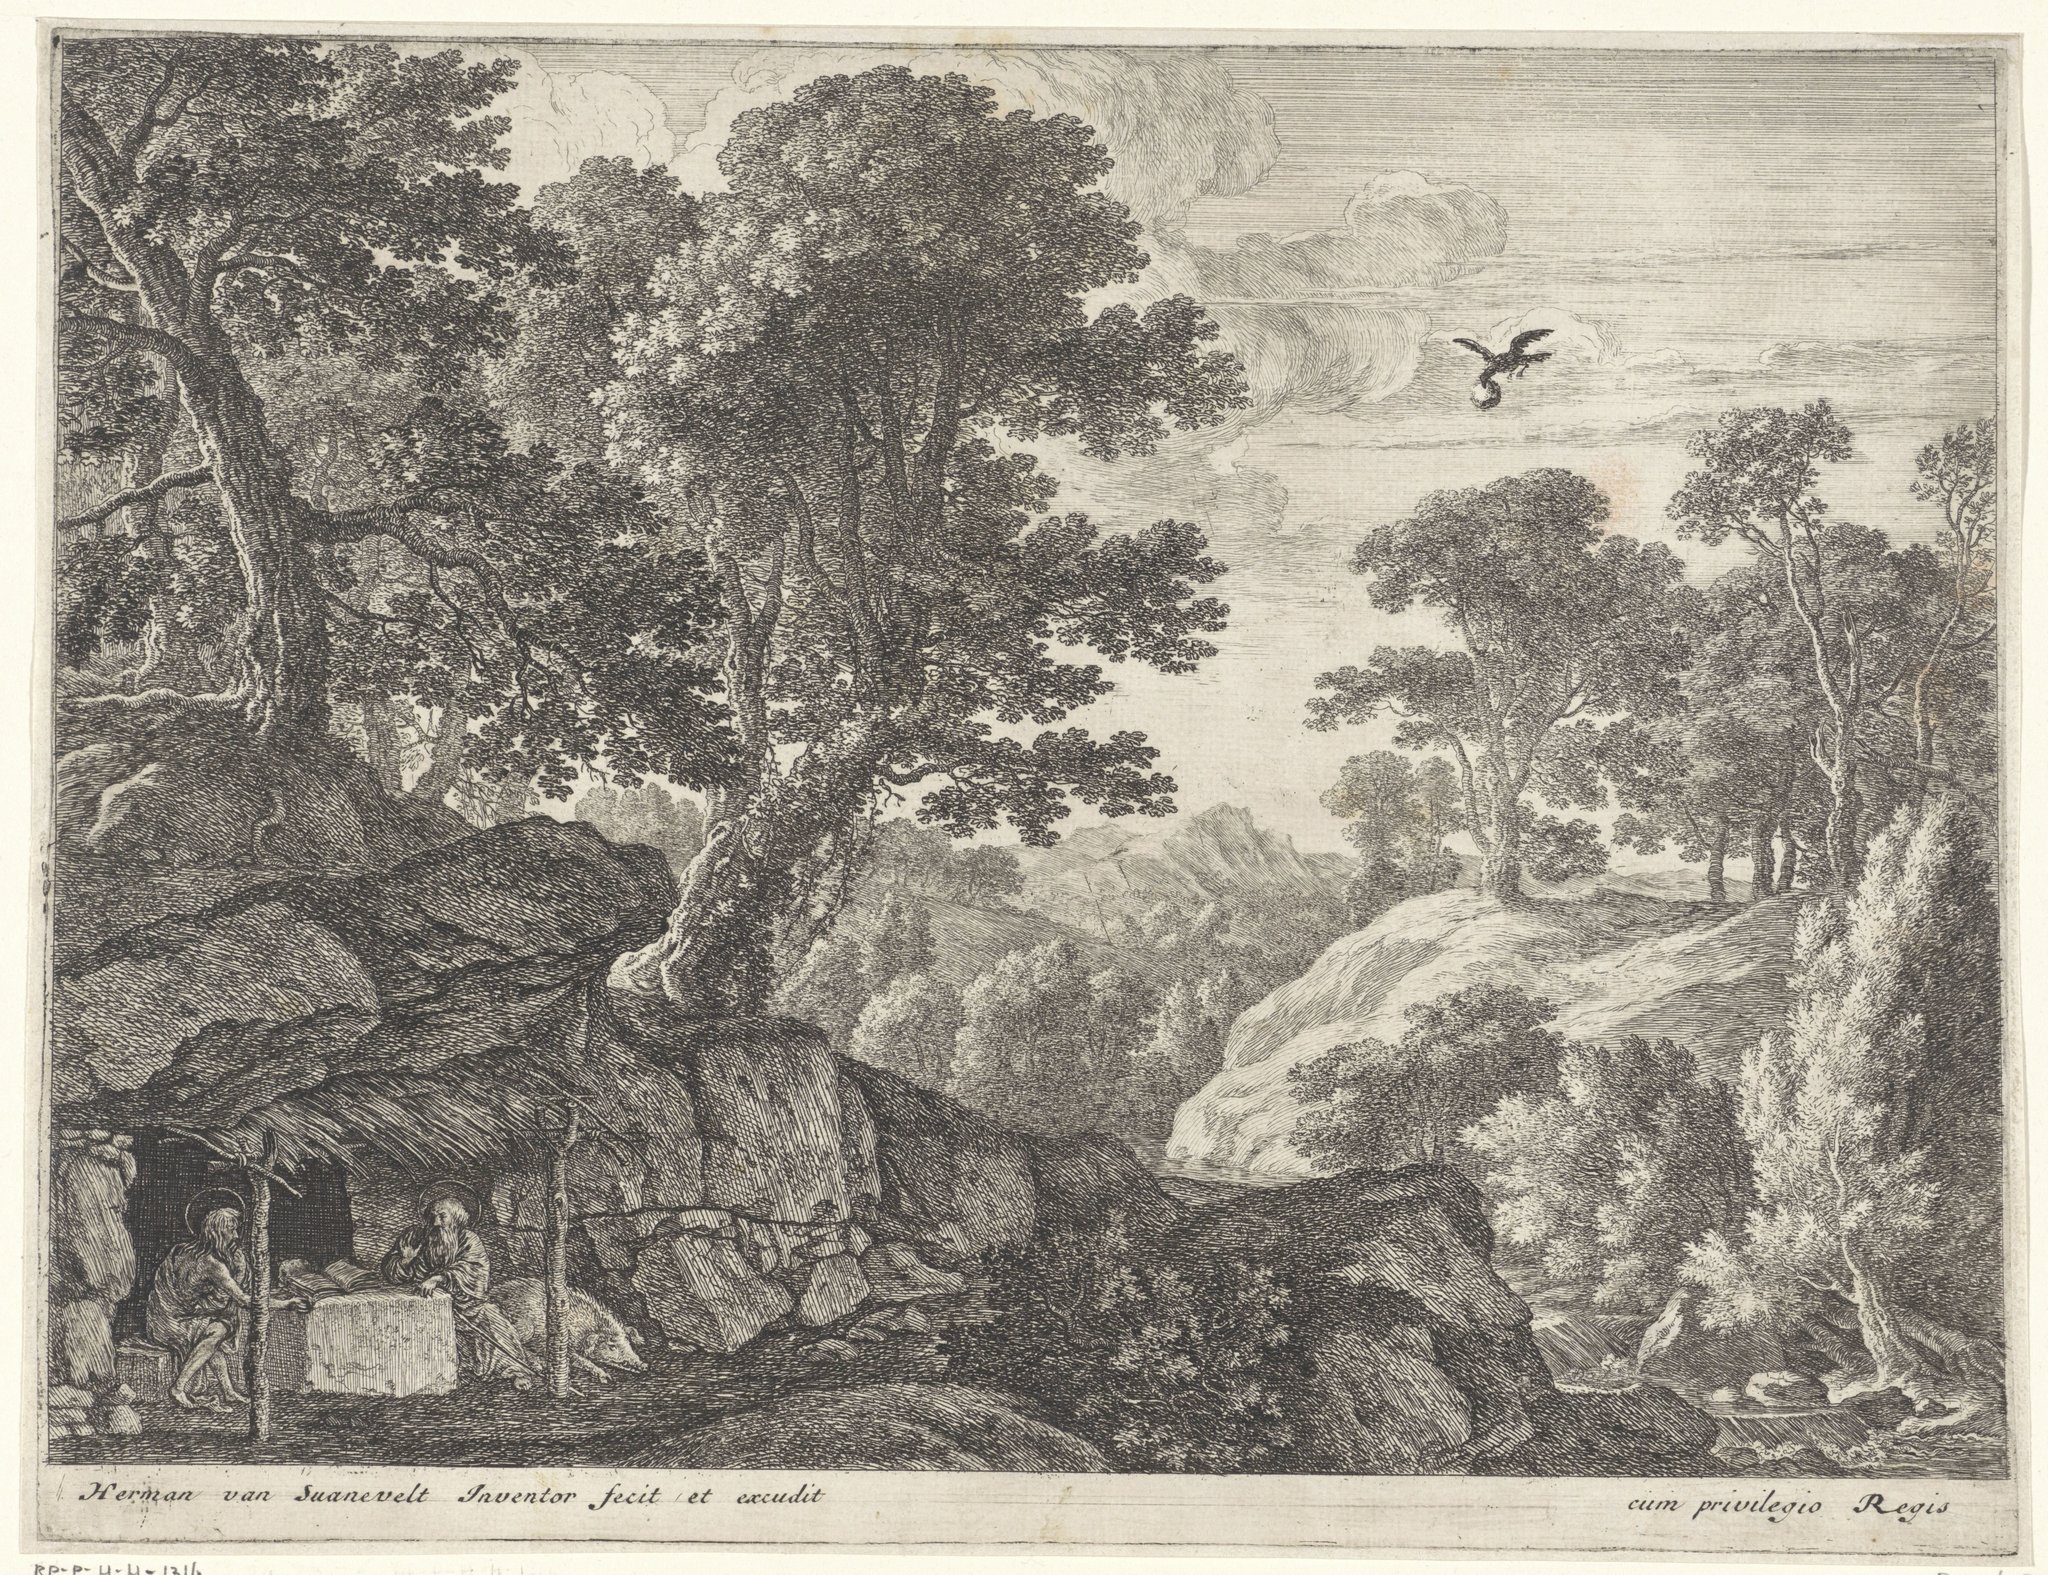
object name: print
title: Landschappen met boetvaardige heiligen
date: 1650-1655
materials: paper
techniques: etching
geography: paris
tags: st. antony abbot visits st. paul the hermit in the desert, song-birds: raven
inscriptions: collector's mark: Lugt 10, collector's mark: Lugt 11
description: In een rotsachtig landschap met boompartijen zitten de heilige Paulus en de heilige Antonius onder een rieten afdak voor een grot. Tussen hen in ligt een opengeslagen boek en een doodskop op een grote steen. Op Antonius' schoot ligt een stok en naast hem slaapt een varken. In de verte rechts vliegt een raaf met brood in zijn snavel in de richting van de twee heiligen.